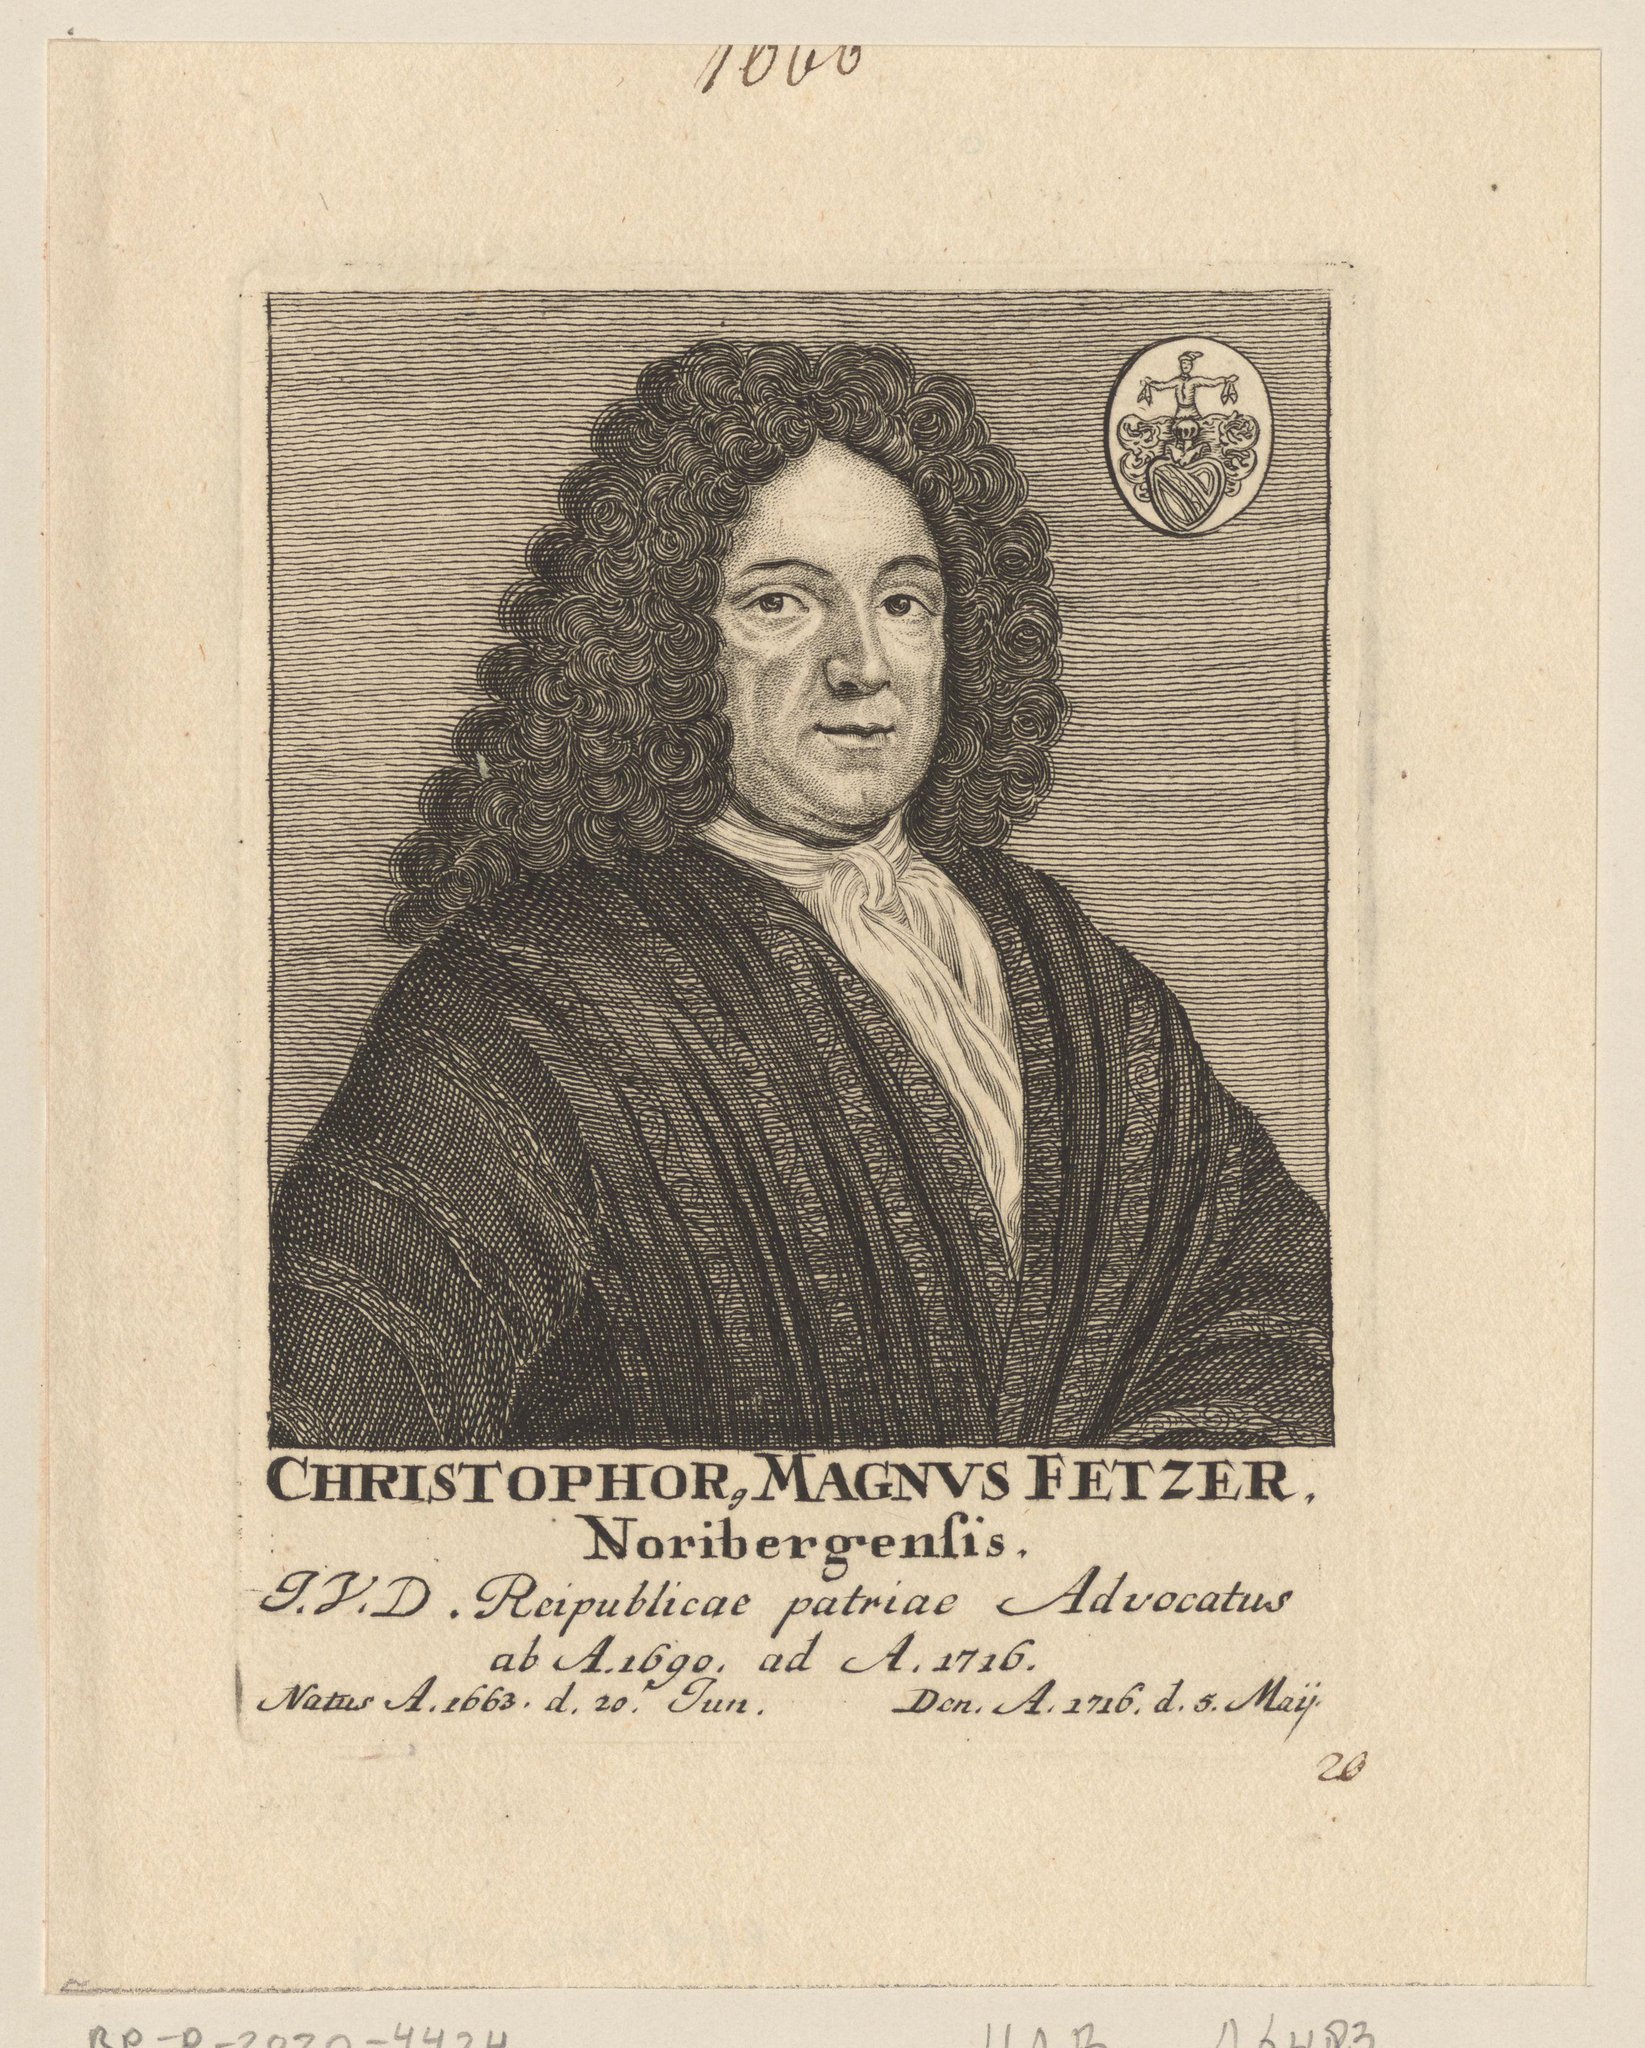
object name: print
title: Portret van Christoph Magnus Fetzer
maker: Anonymous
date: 1725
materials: paper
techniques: engraving, etching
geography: germany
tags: historical persons, armorial bearing, heraldry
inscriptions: number: ‘20’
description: Prent waarschijnlijk uit: Roth-Scholtz, Friedrich. Icones virorum omnium ordinum eruditione omnique item genere (...). Neurenberg: erven Johann Daniel Tauber, 1725.